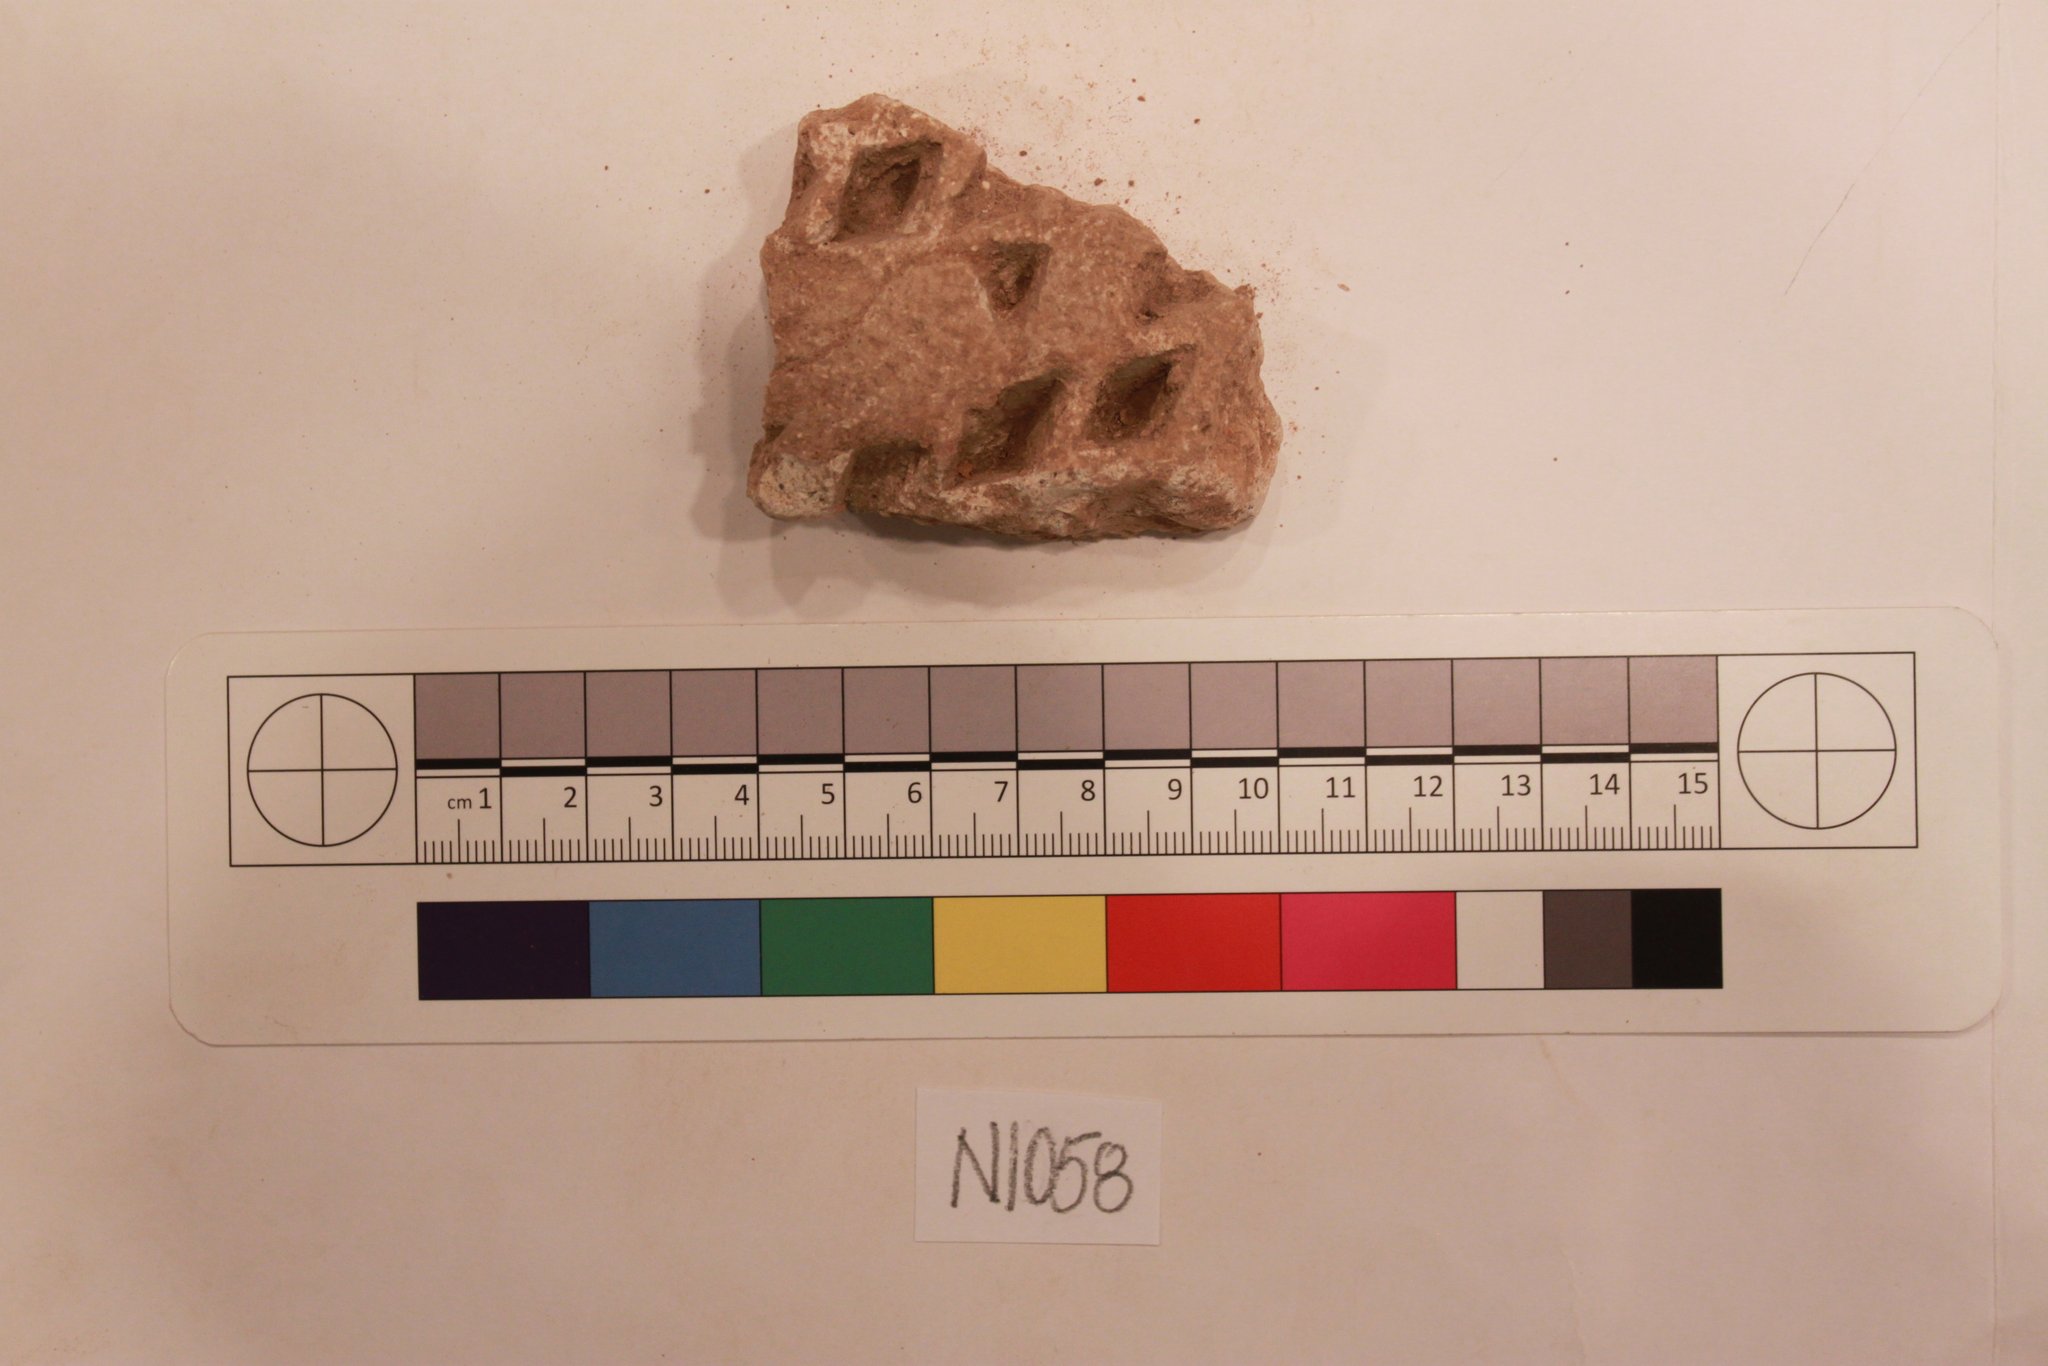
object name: fragment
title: Stucco Fragment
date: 701-1200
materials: plaster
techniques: carving, painting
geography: iran